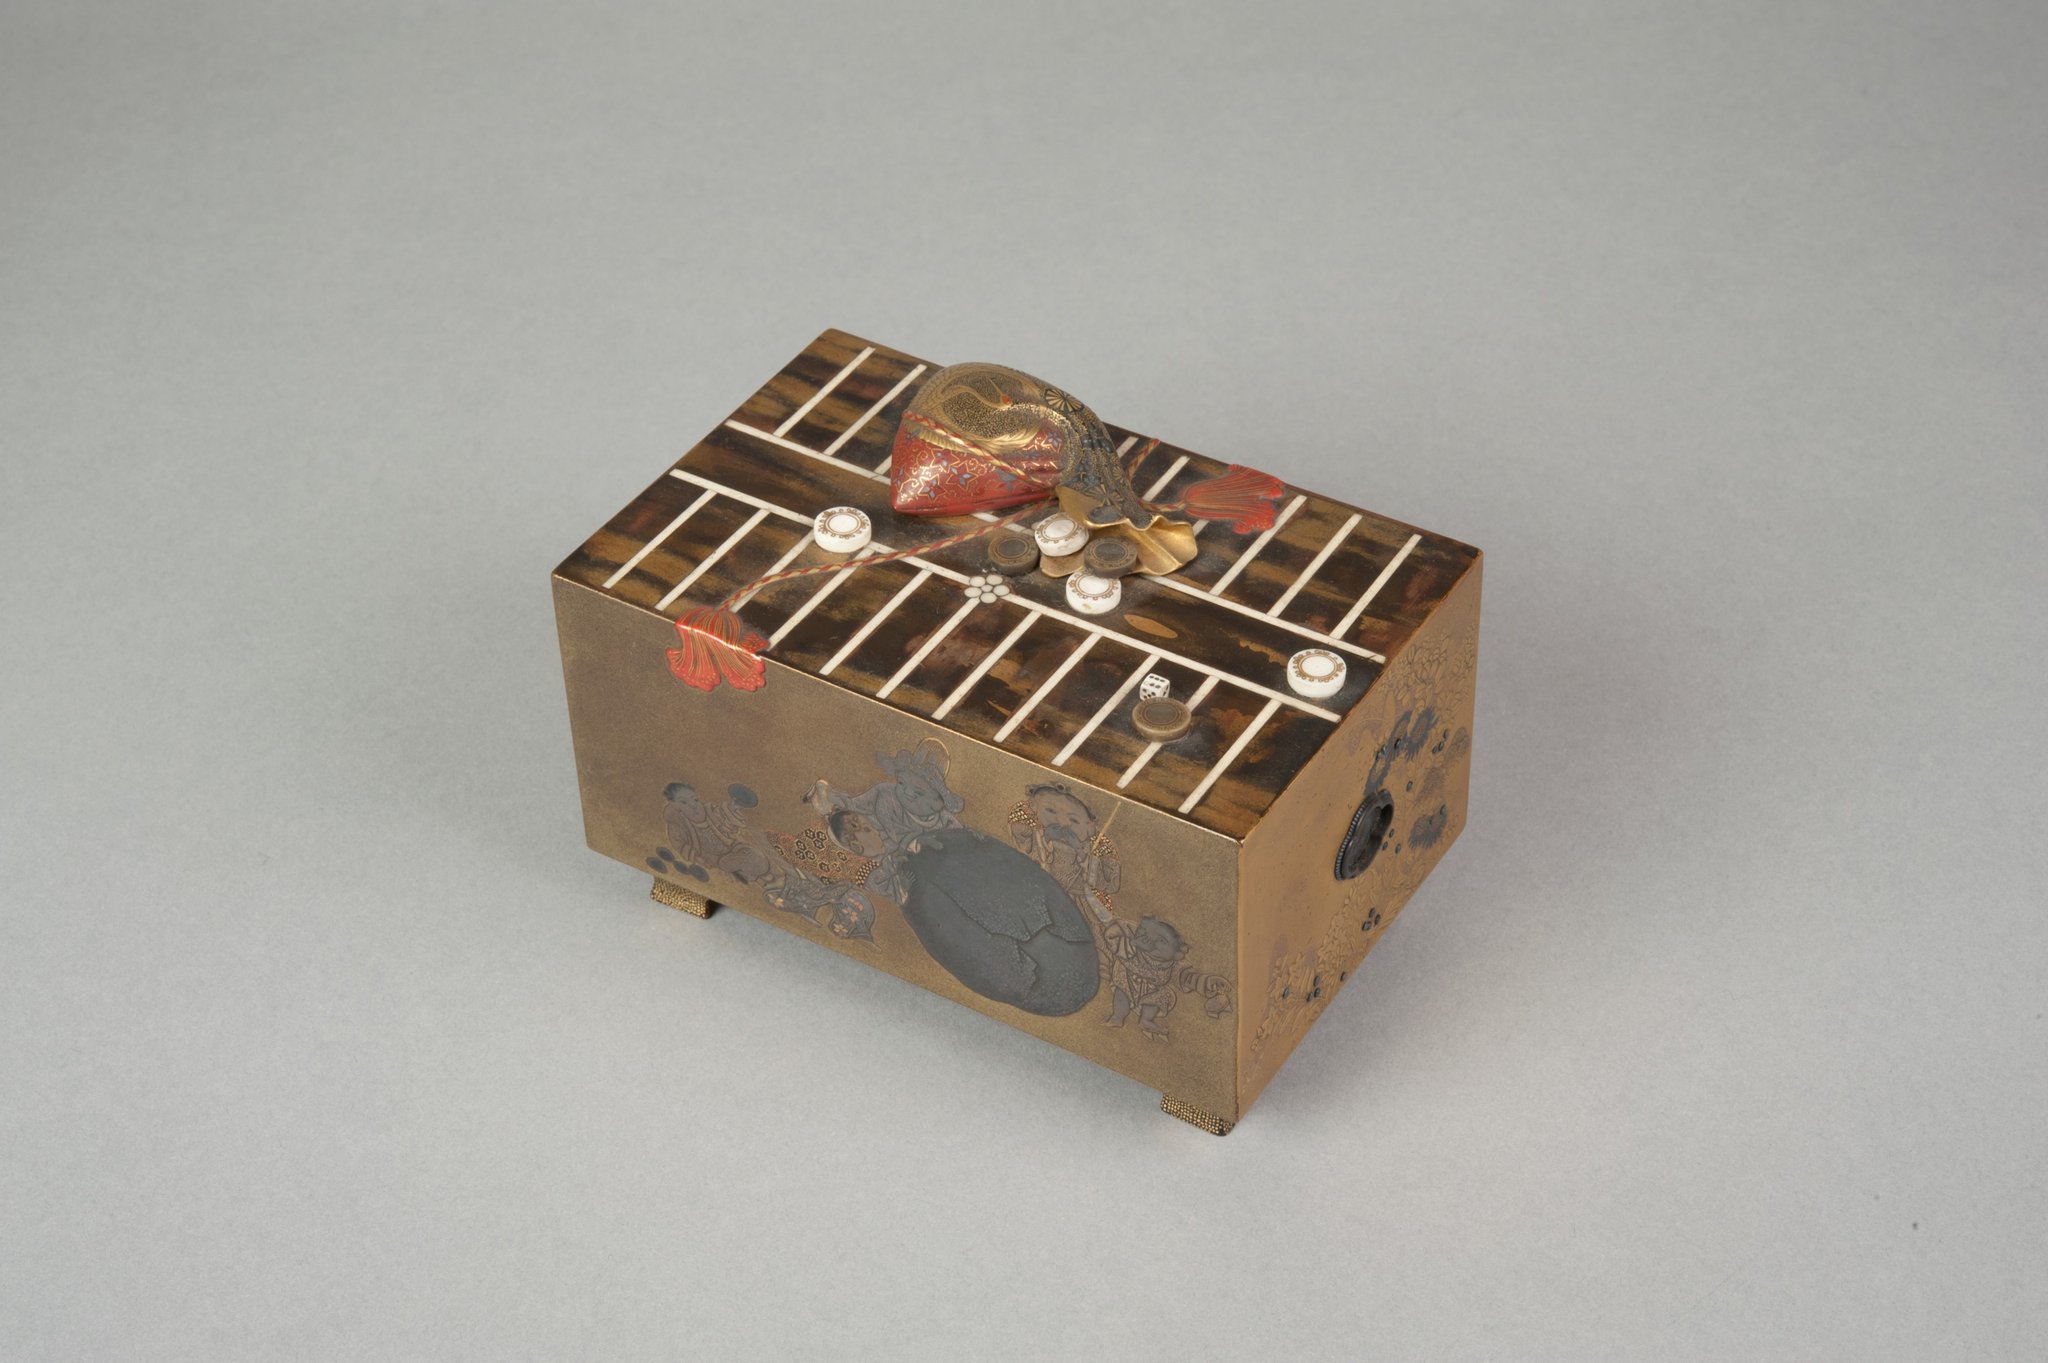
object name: incense box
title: Incense Box Cover with Design of Backgammon Board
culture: japanese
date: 1834-1866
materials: gold, lacquer, wood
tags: games